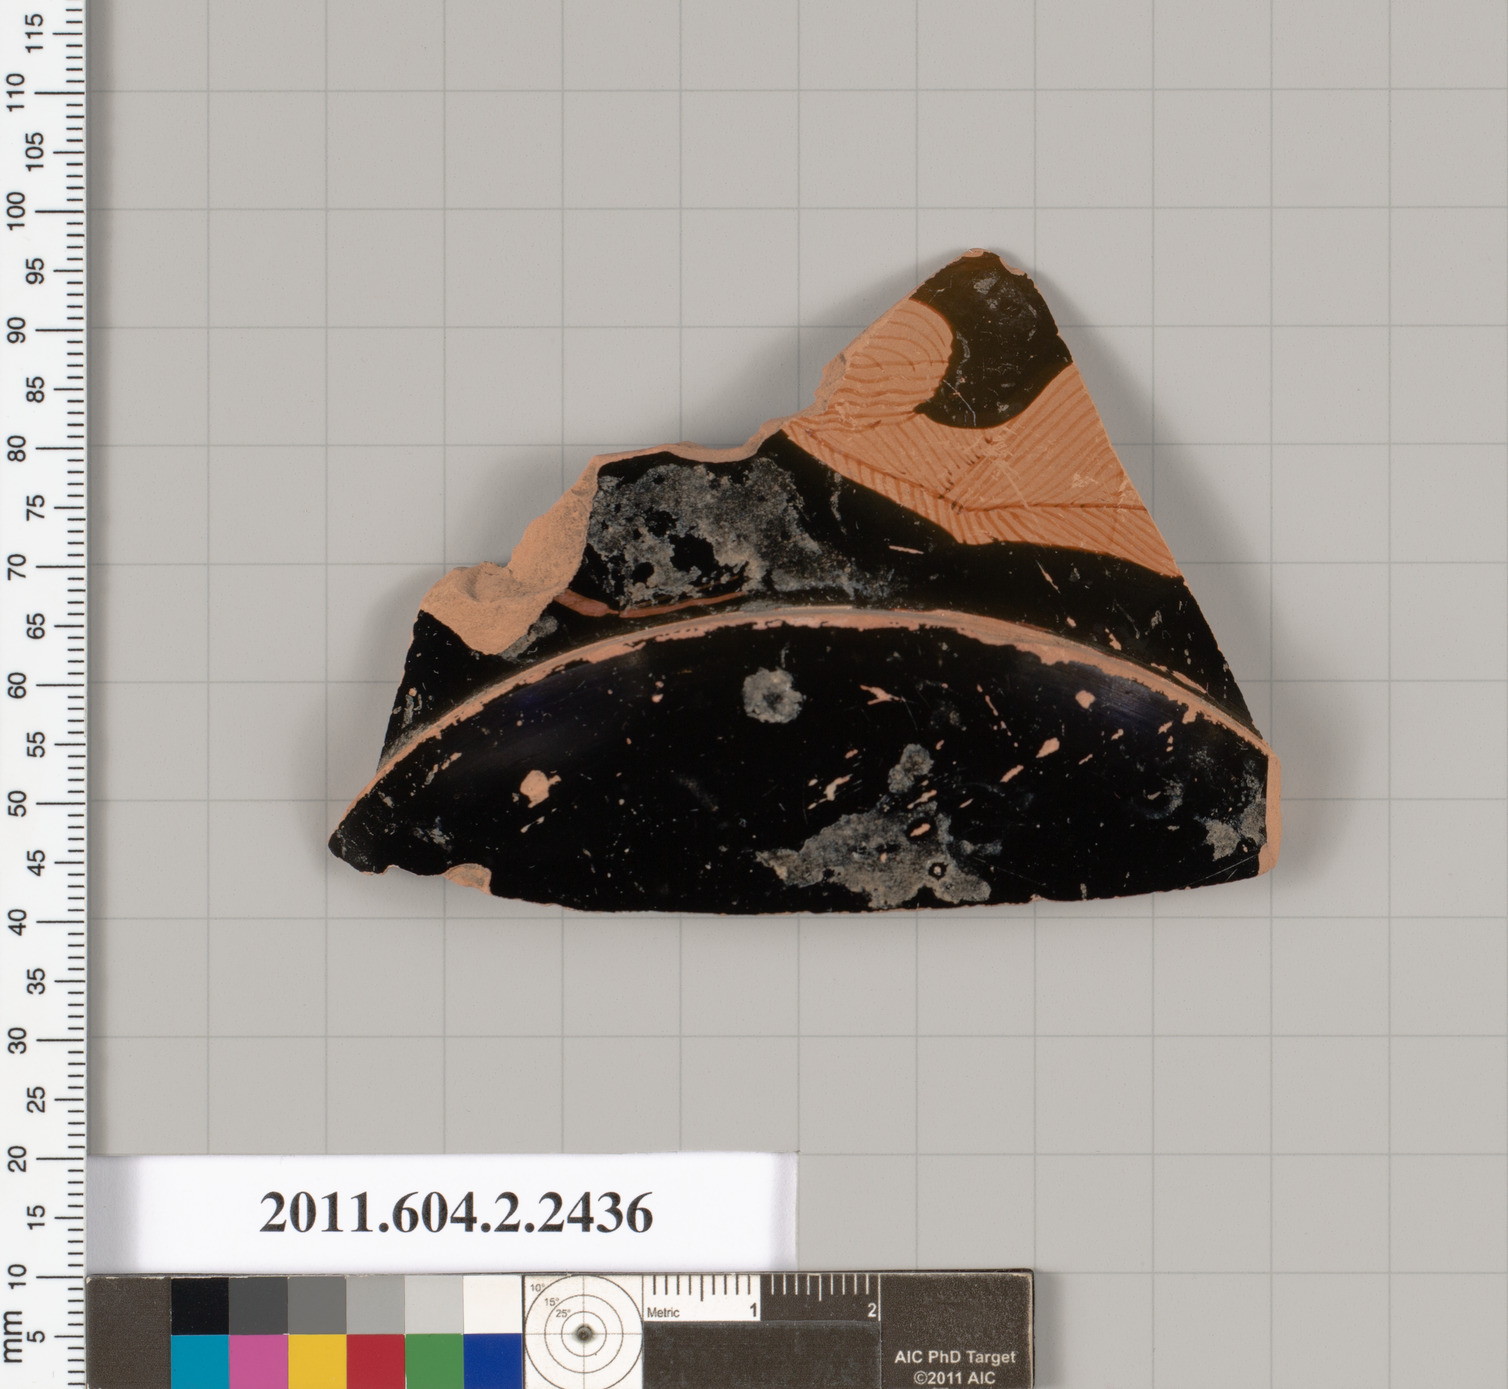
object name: kantharos fragment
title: Terracotta fragment of a kantharos (drinking cup with high handles)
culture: greek, attic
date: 490-470 BCE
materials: terracotta